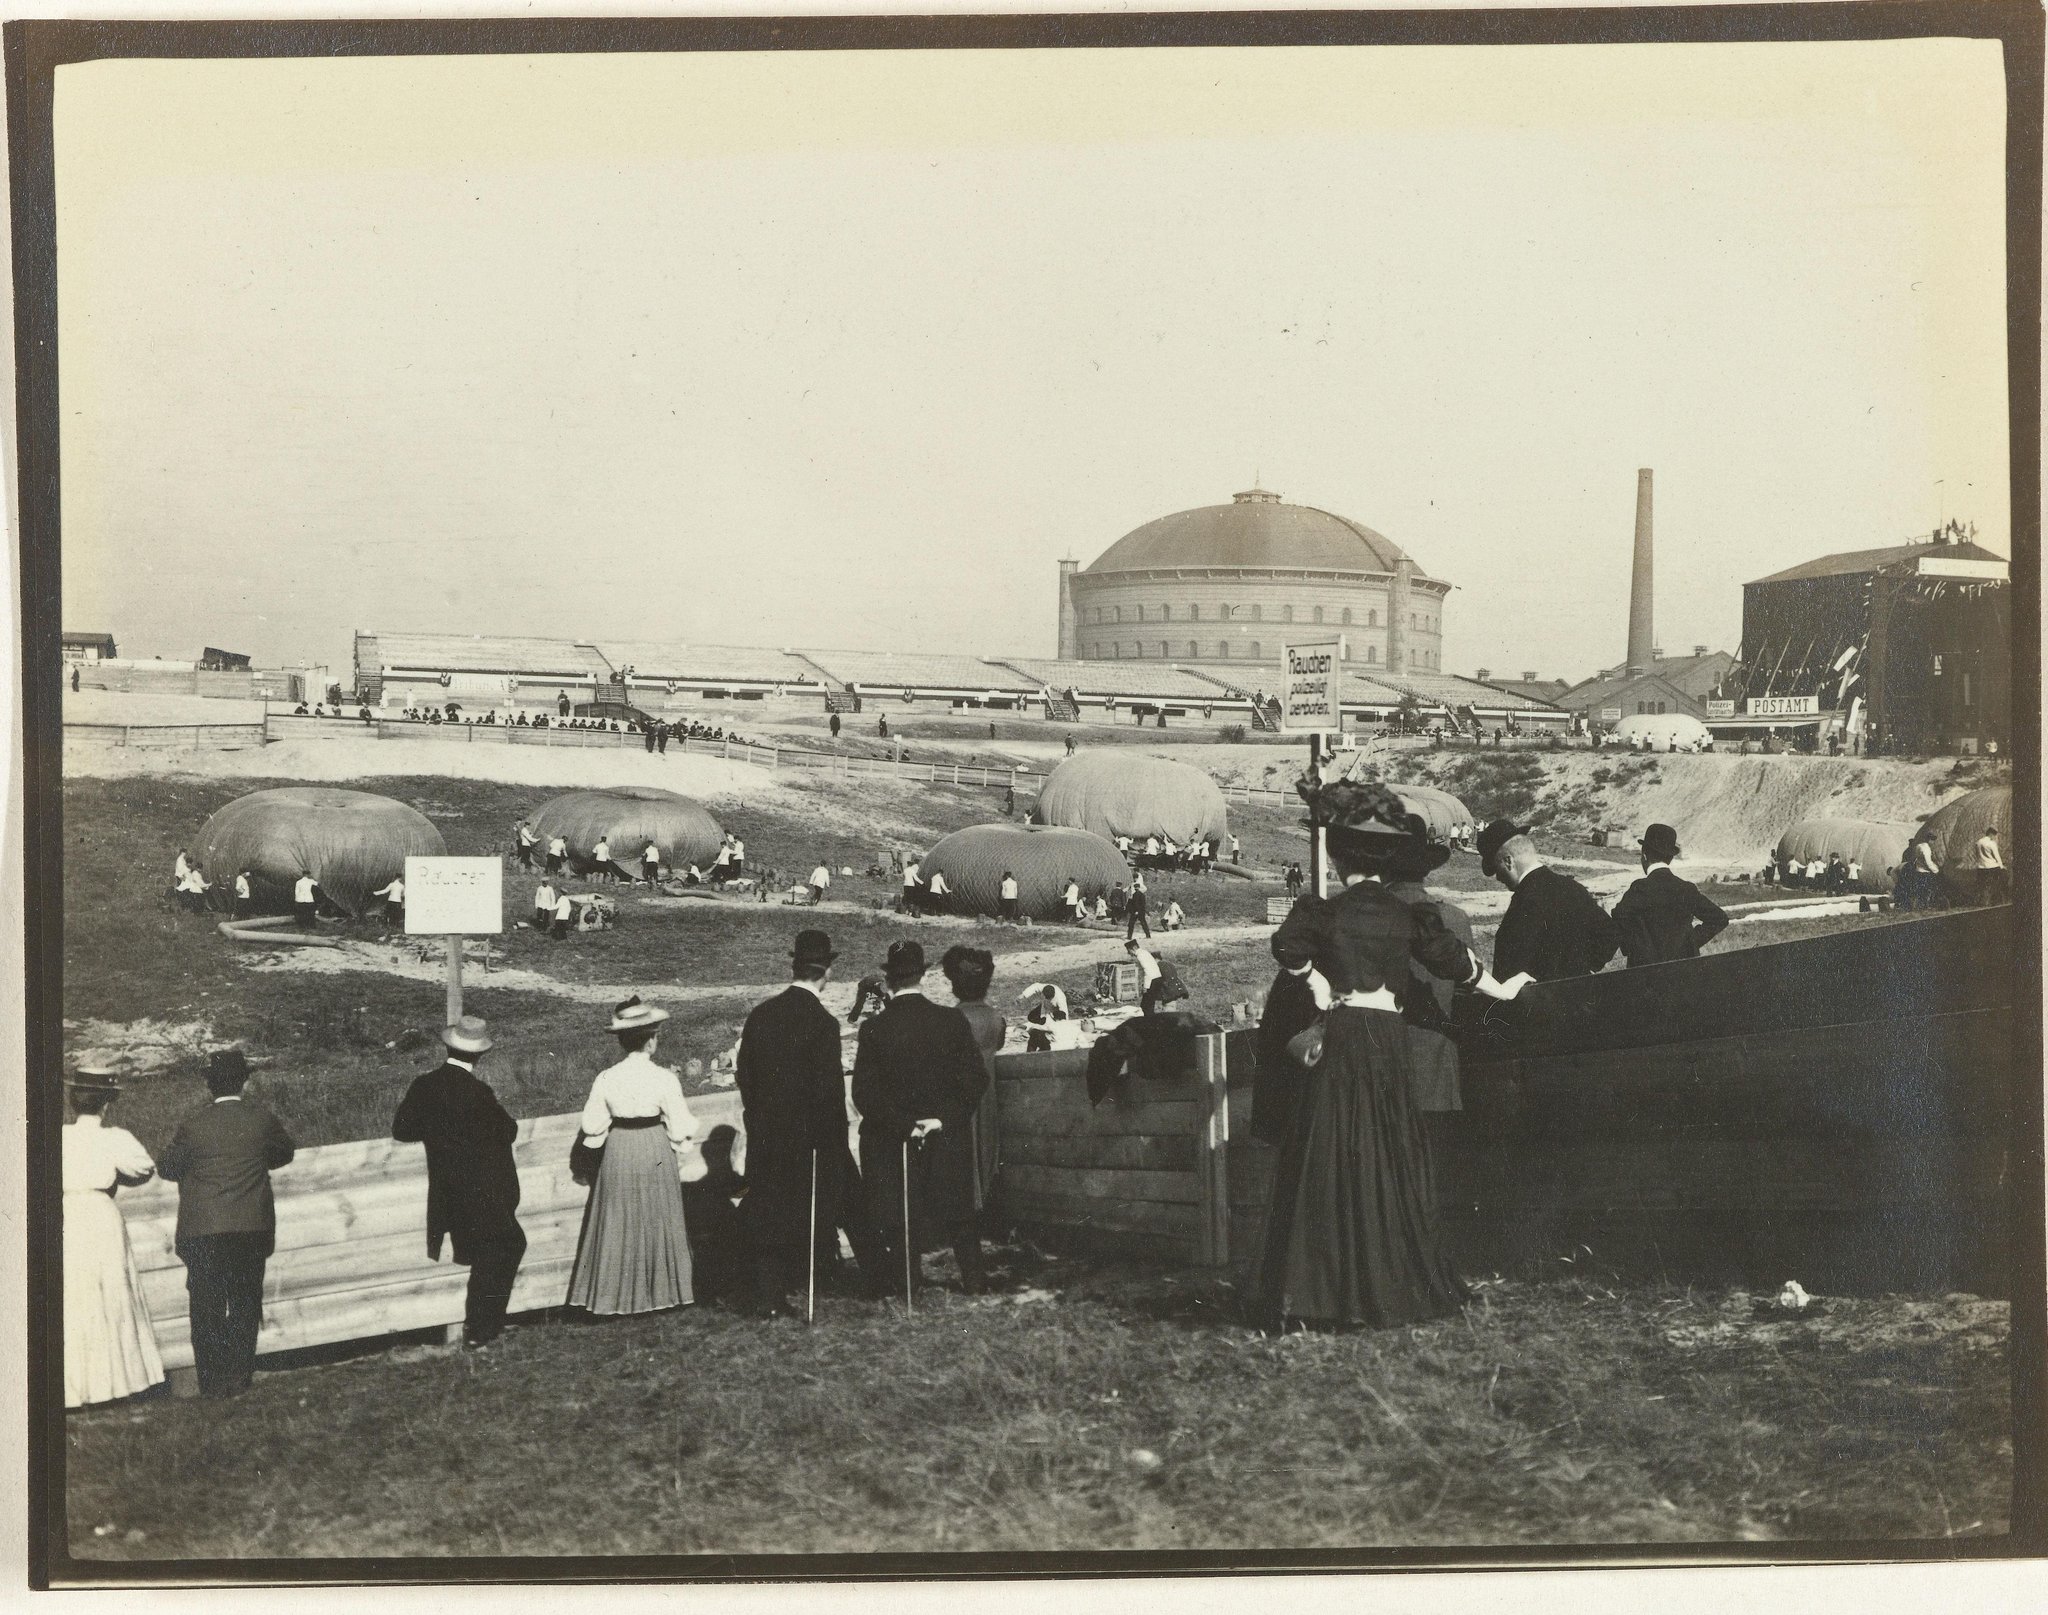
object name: photograph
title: The Third Gordon Bennett Balloon Race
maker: Anonymous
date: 1908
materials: paper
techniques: gelatin silver print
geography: schmargendorf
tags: gasworks, balloon (aviation)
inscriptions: annotation: ‘Schmargendorf/ 10/10/08/ 37906’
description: Op de grond zeven ballonnen die worden opgeblazen, met mensen eromheen. Op de voorgrond publiek. Op de achtergrond de gebouwen van de gasfabriek in Schmargendorf.